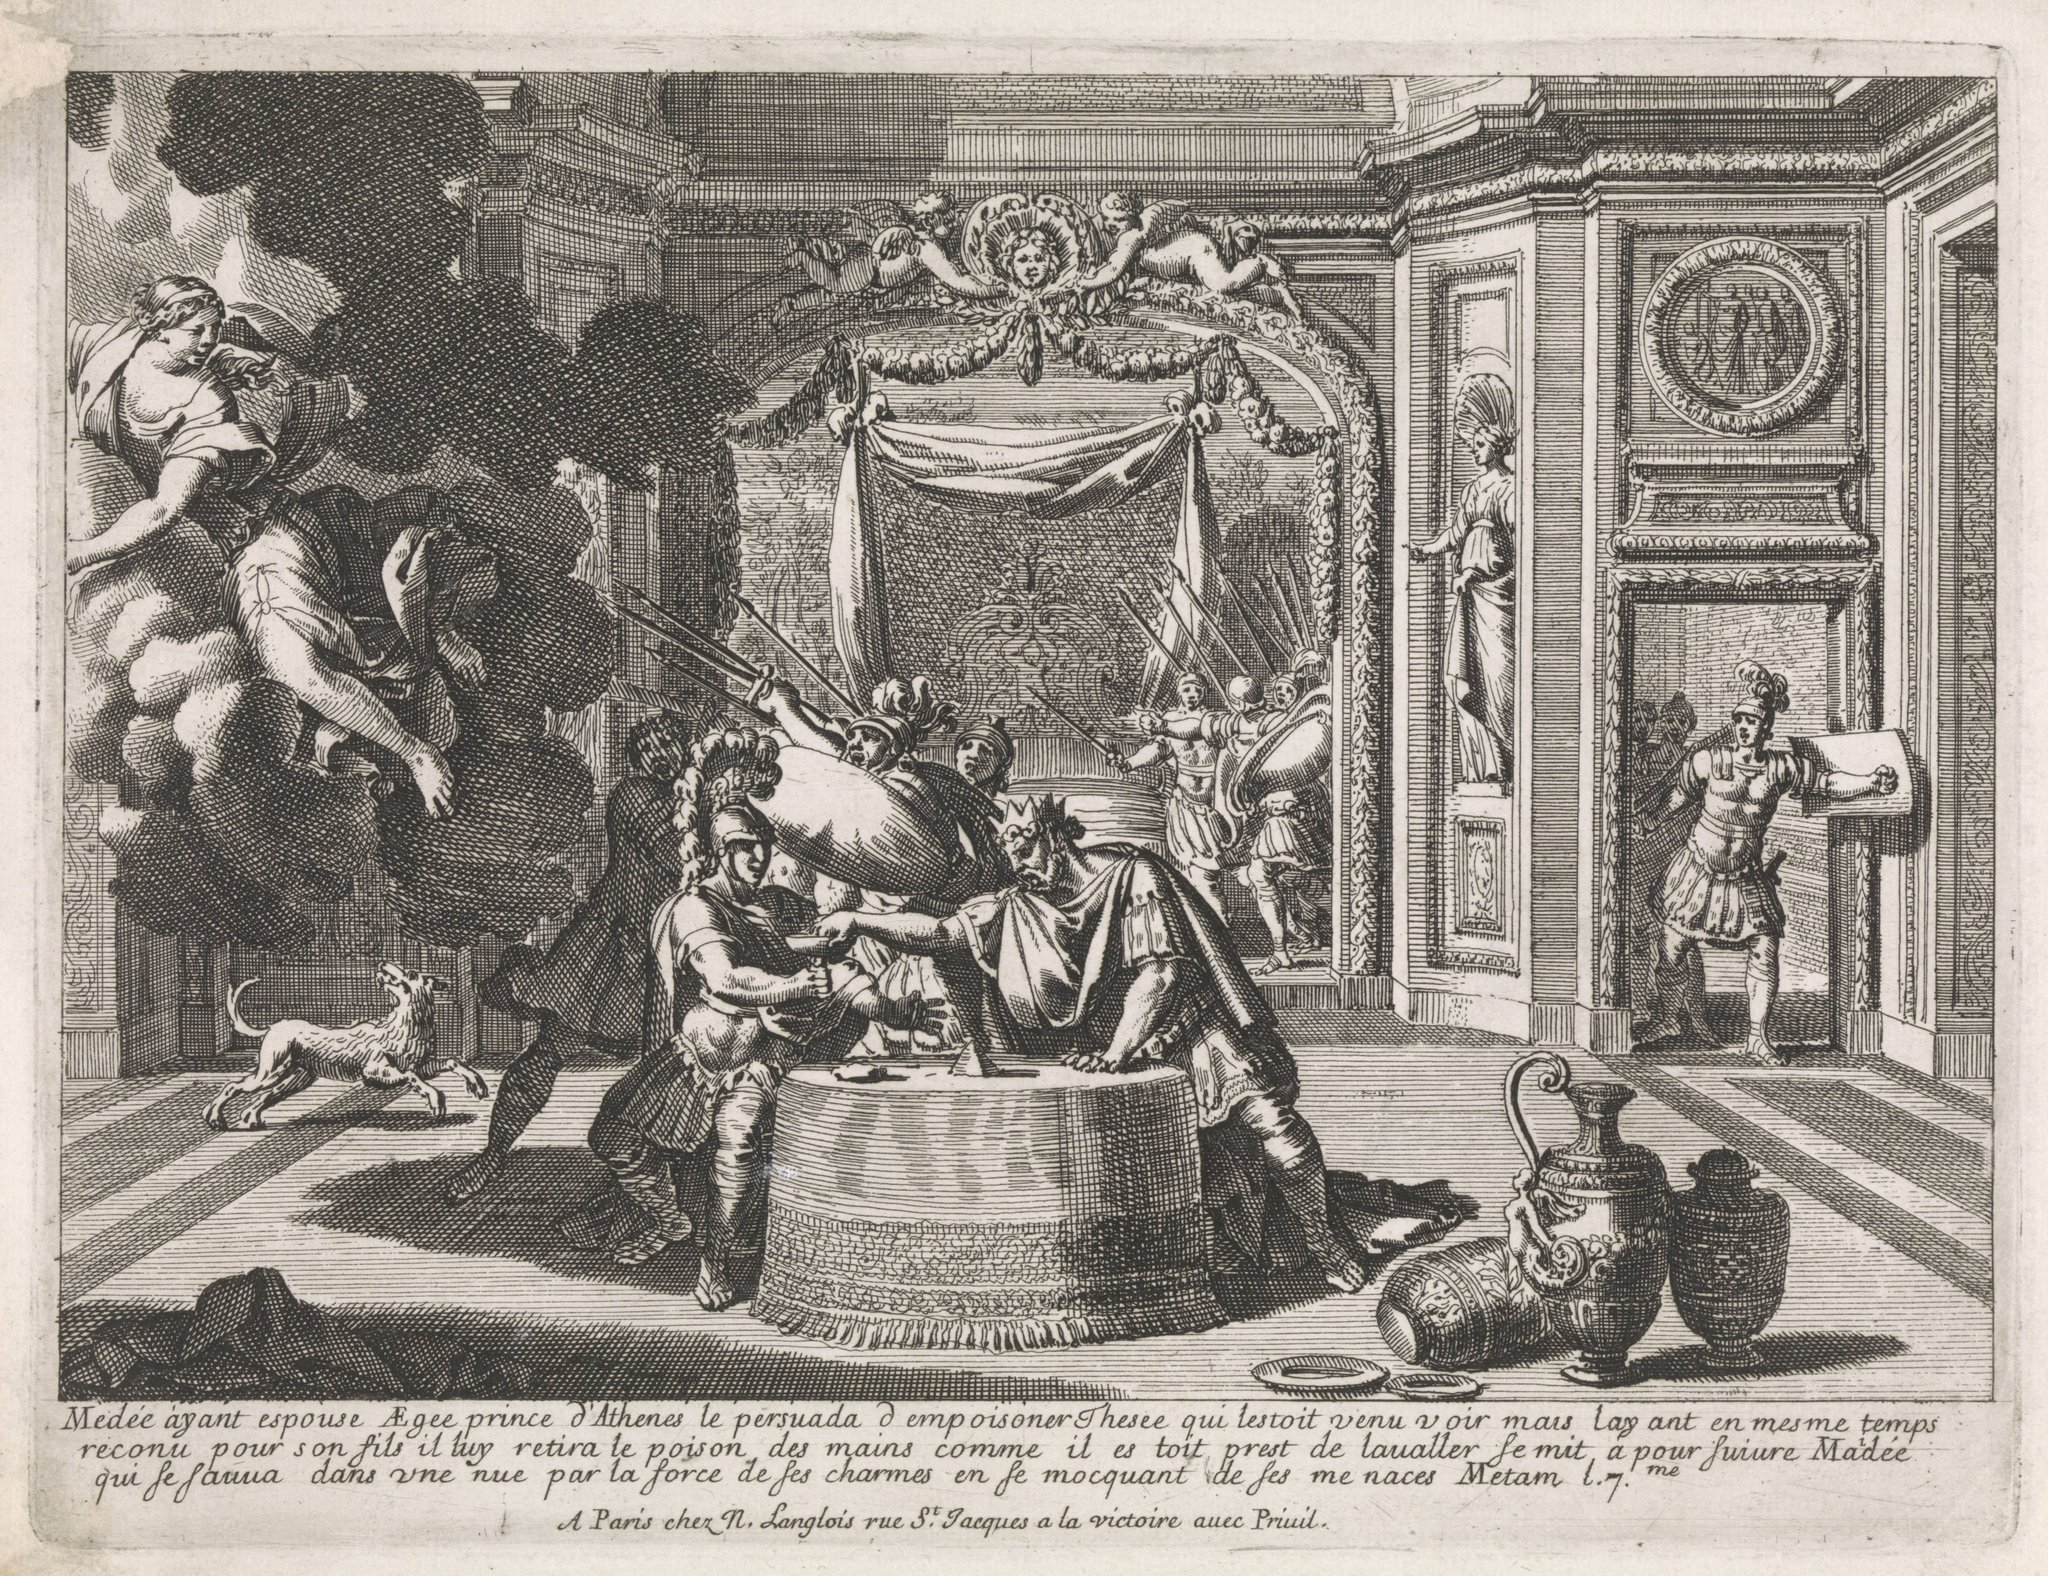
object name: ornament print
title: Alkoof met Aigeus en Theseus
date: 1662-1670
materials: paper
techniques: etching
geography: france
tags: at a banquet aegeus recognizes his son theseus just in time to save him from being poisoned by medea, theseus in pursuit of medea; she eludes him by casting a cloud about herself, and disappears in her chariot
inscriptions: collector's mark: Lugt 2228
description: Koning Aigeus verhindert dat zijn zoon Theseus het gif opdrinkt. Medea vliegt linksboven weg voor de binnenstormende soldaten. Onderaan staan drie regels Franse tekst.